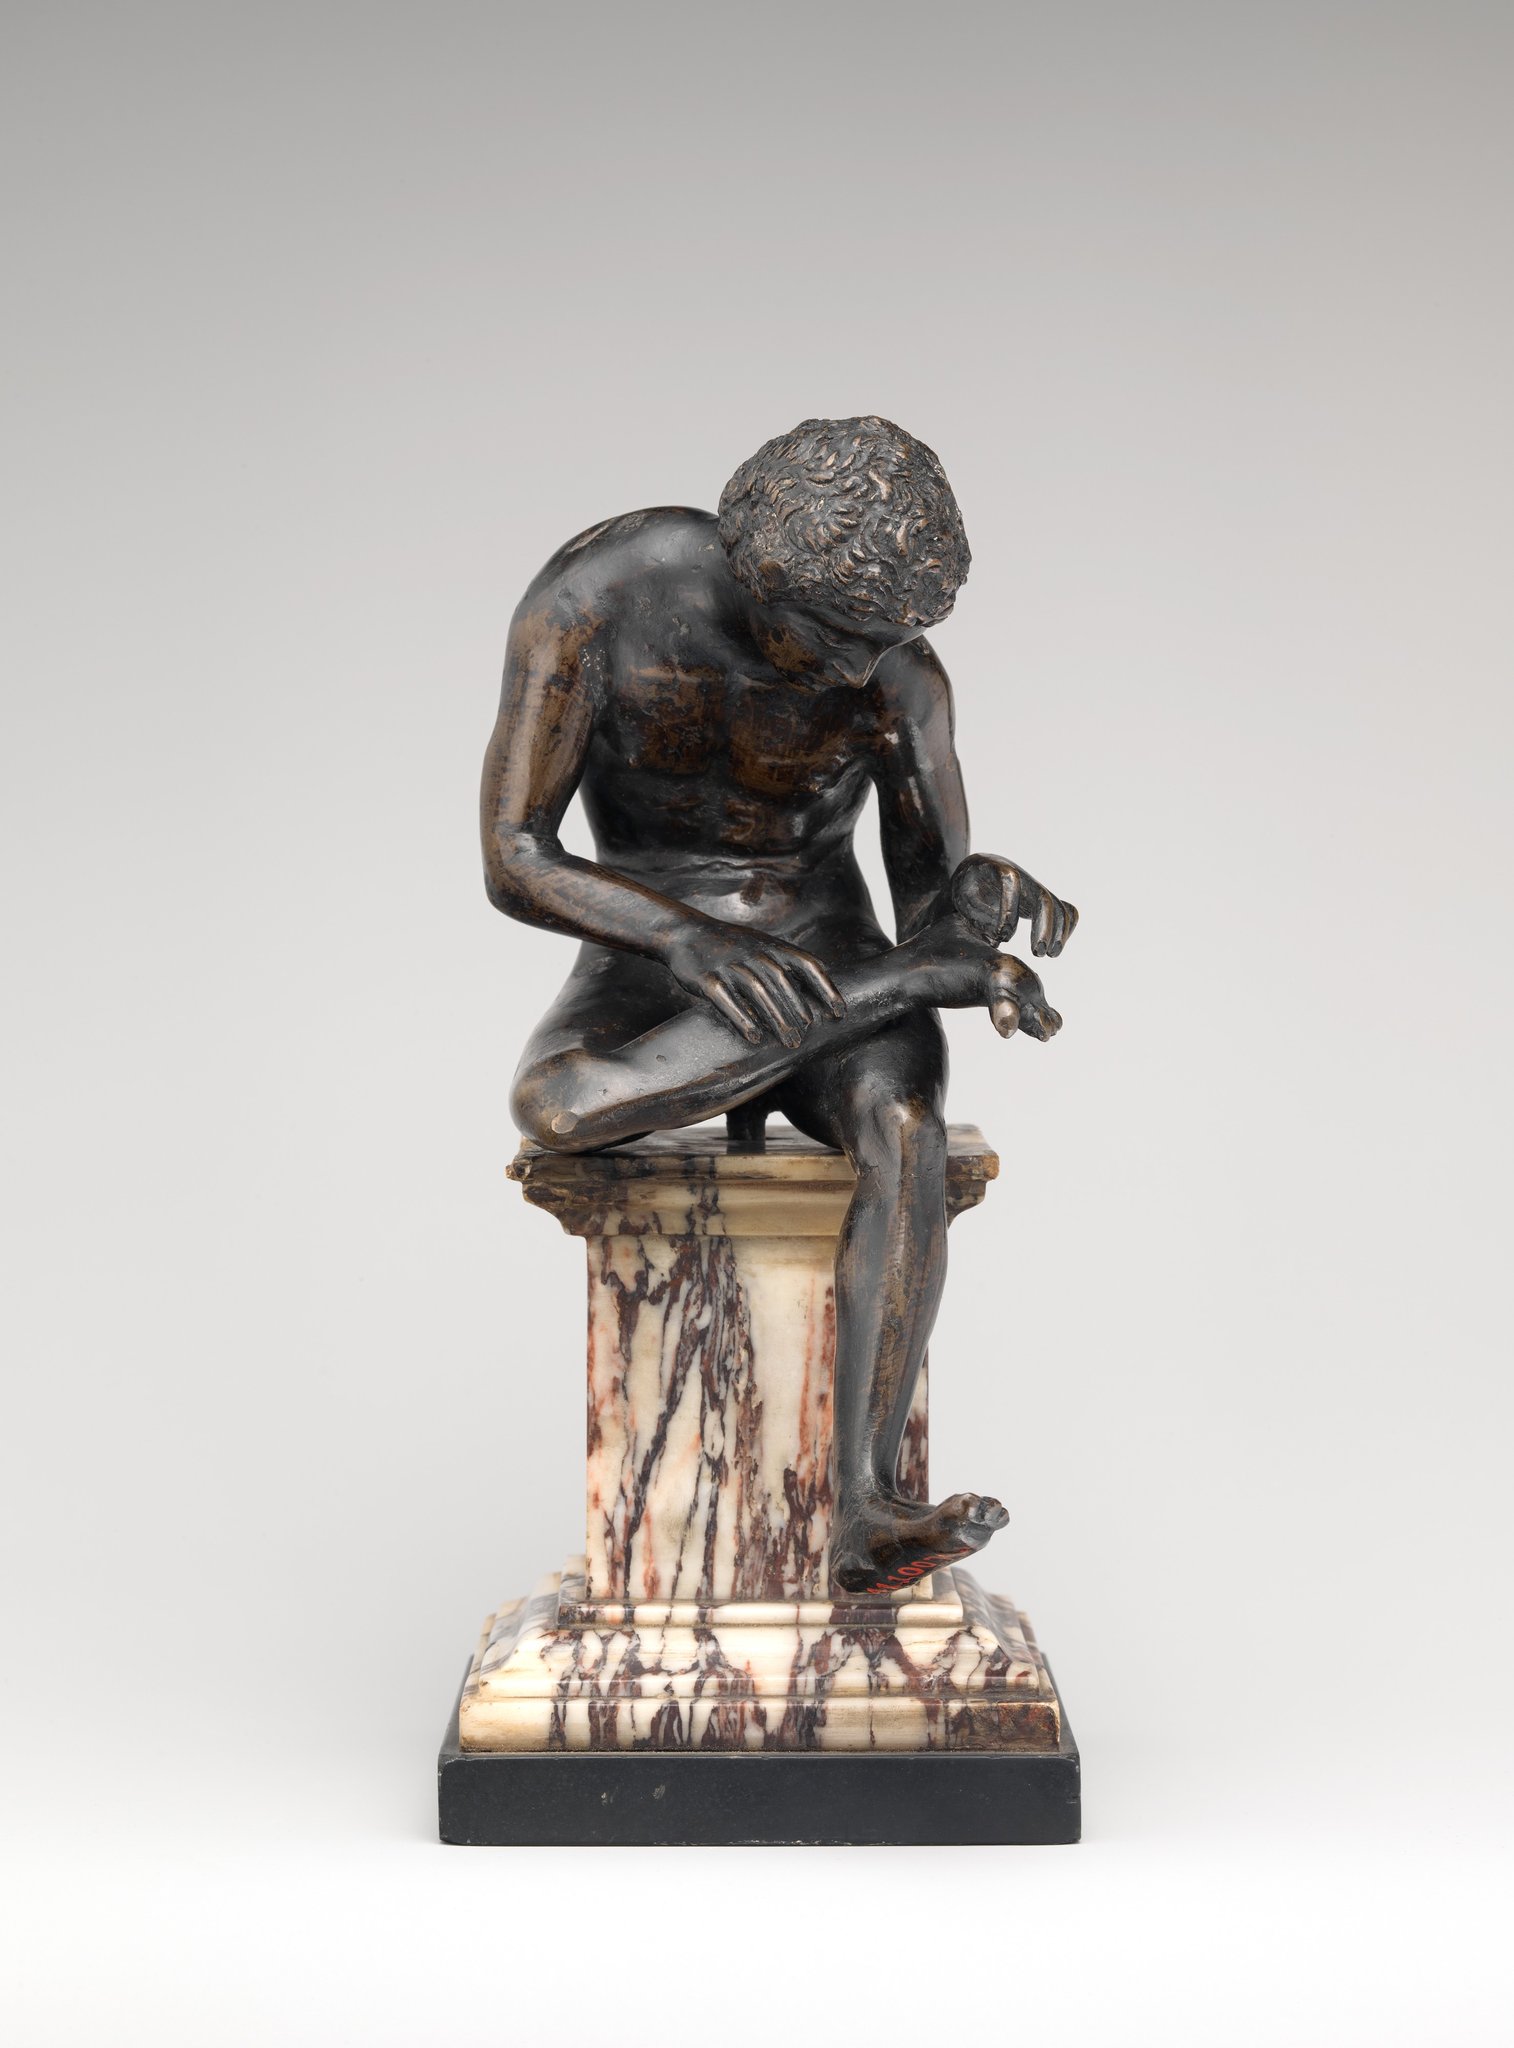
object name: statuette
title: Spinario (boy pulling a thorn from his foot)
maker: severo calzetta da ravenna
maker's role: artist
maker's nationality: italian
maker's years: 1496-1543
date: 1501-1550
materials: bronze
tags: boys